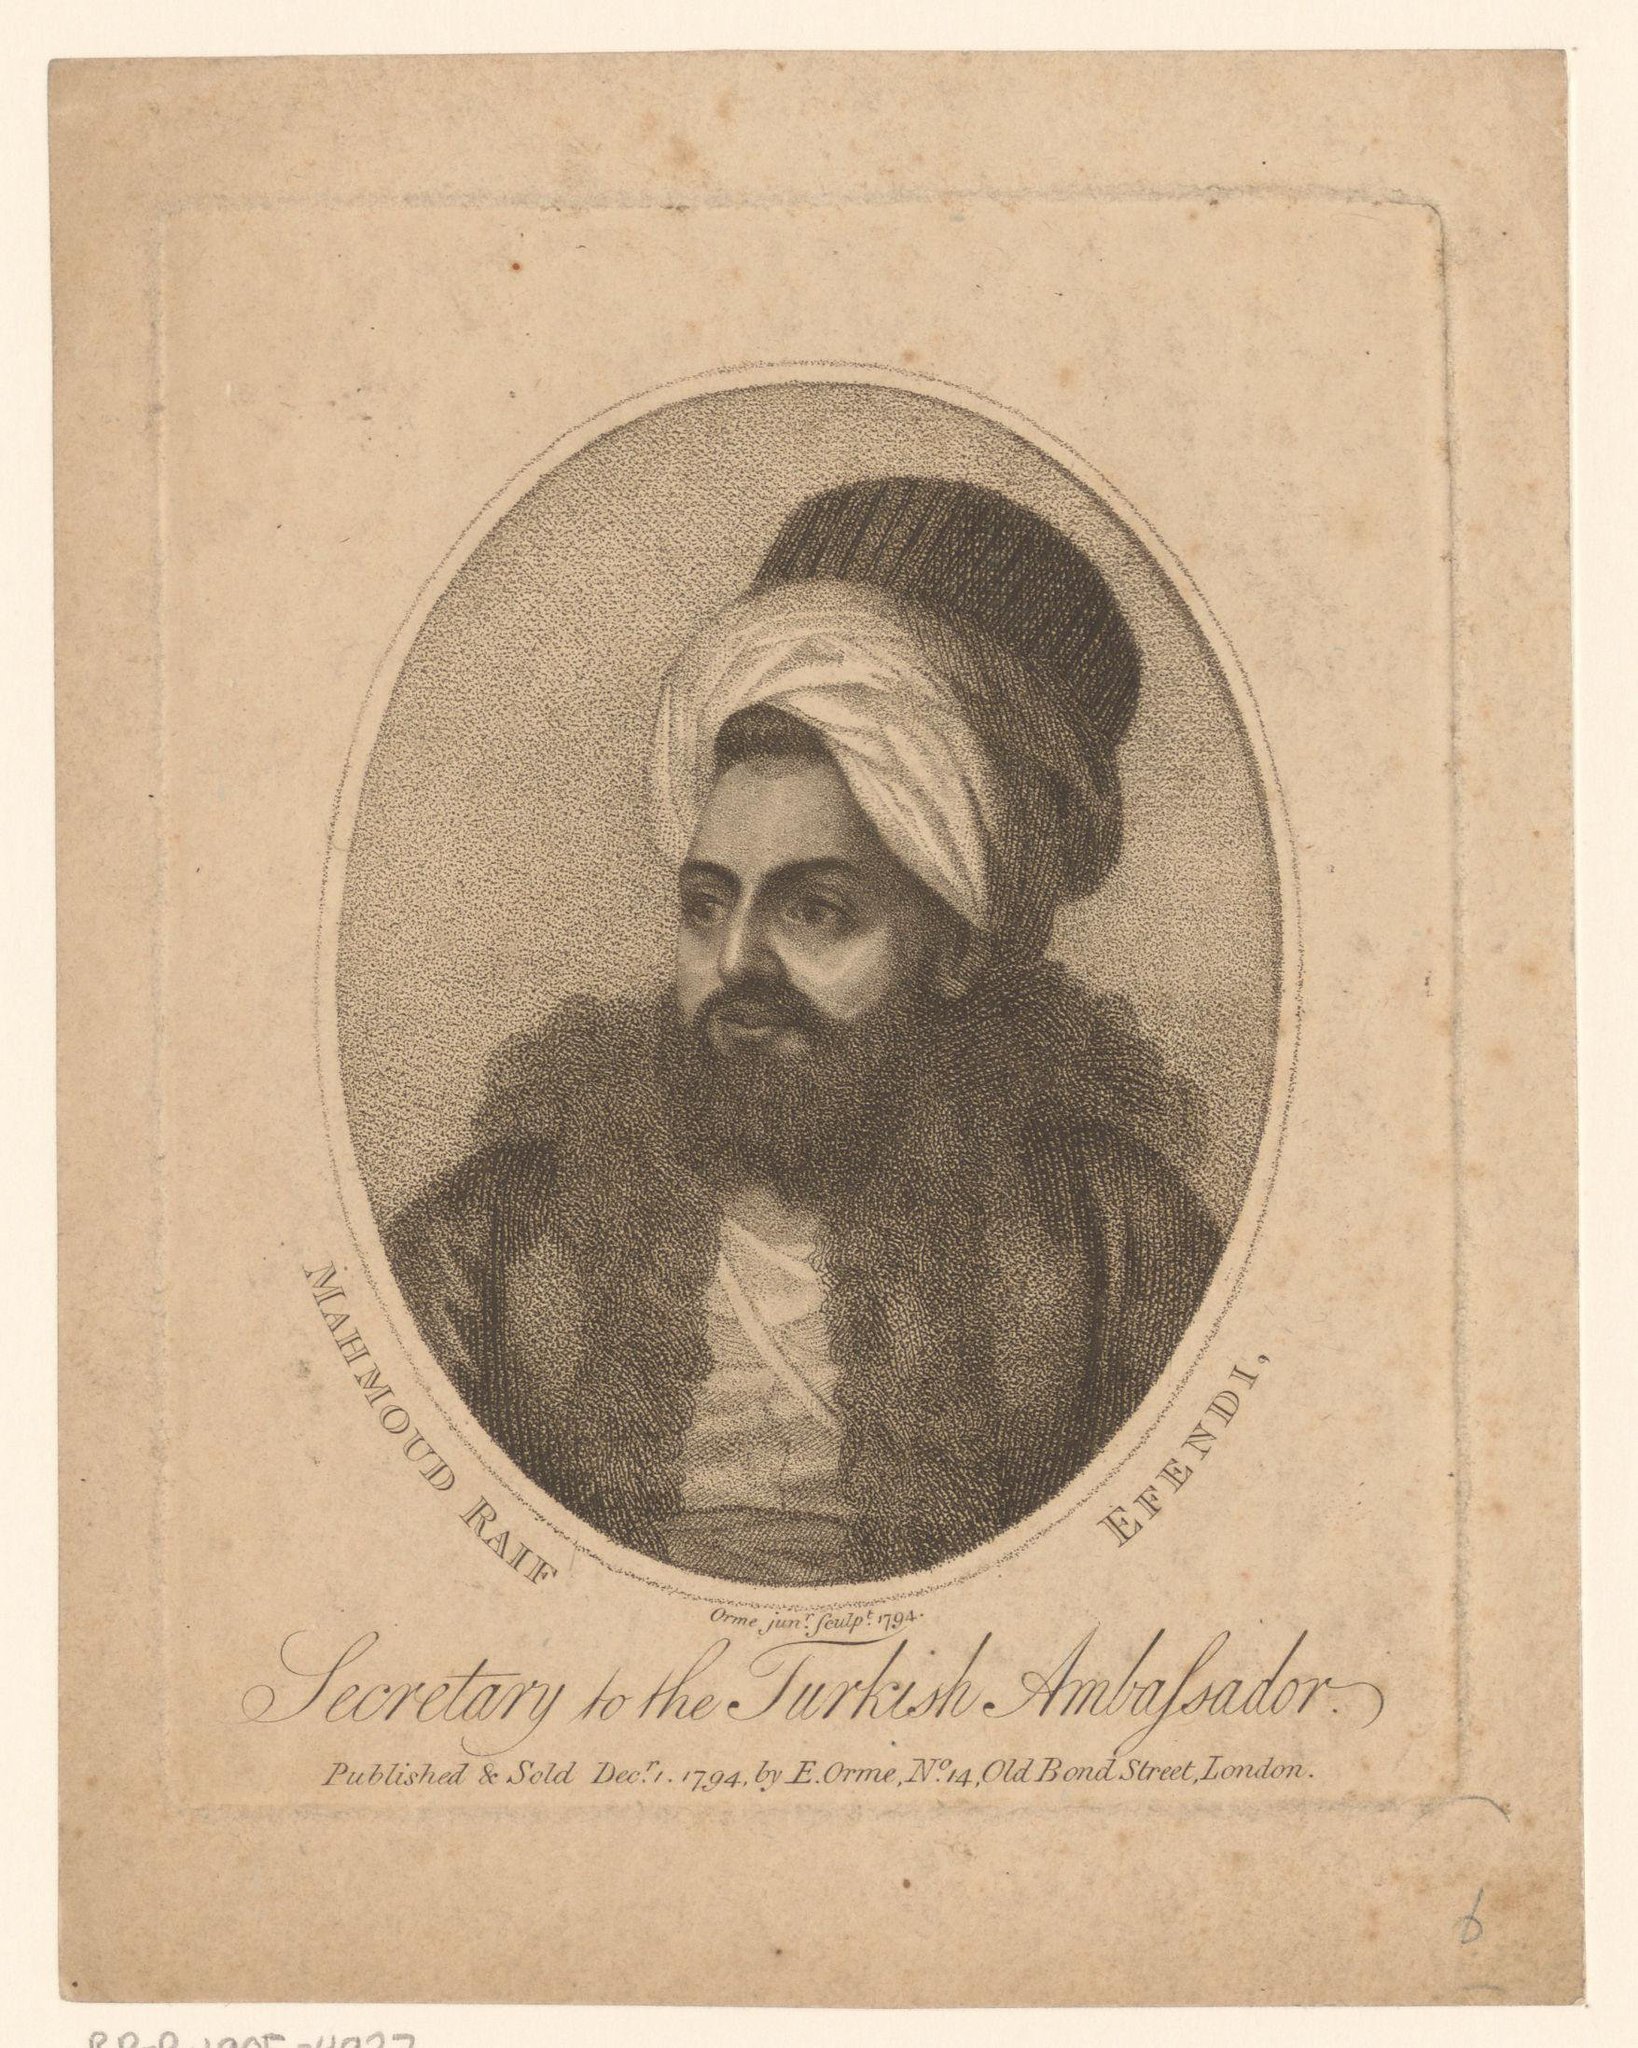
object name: print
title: Portret van Mahmud Raif Efendi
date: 1794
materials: paper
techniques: etching, engraving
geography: london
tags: historical persons, ambassador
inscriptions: collector's mark: Lugt 2228